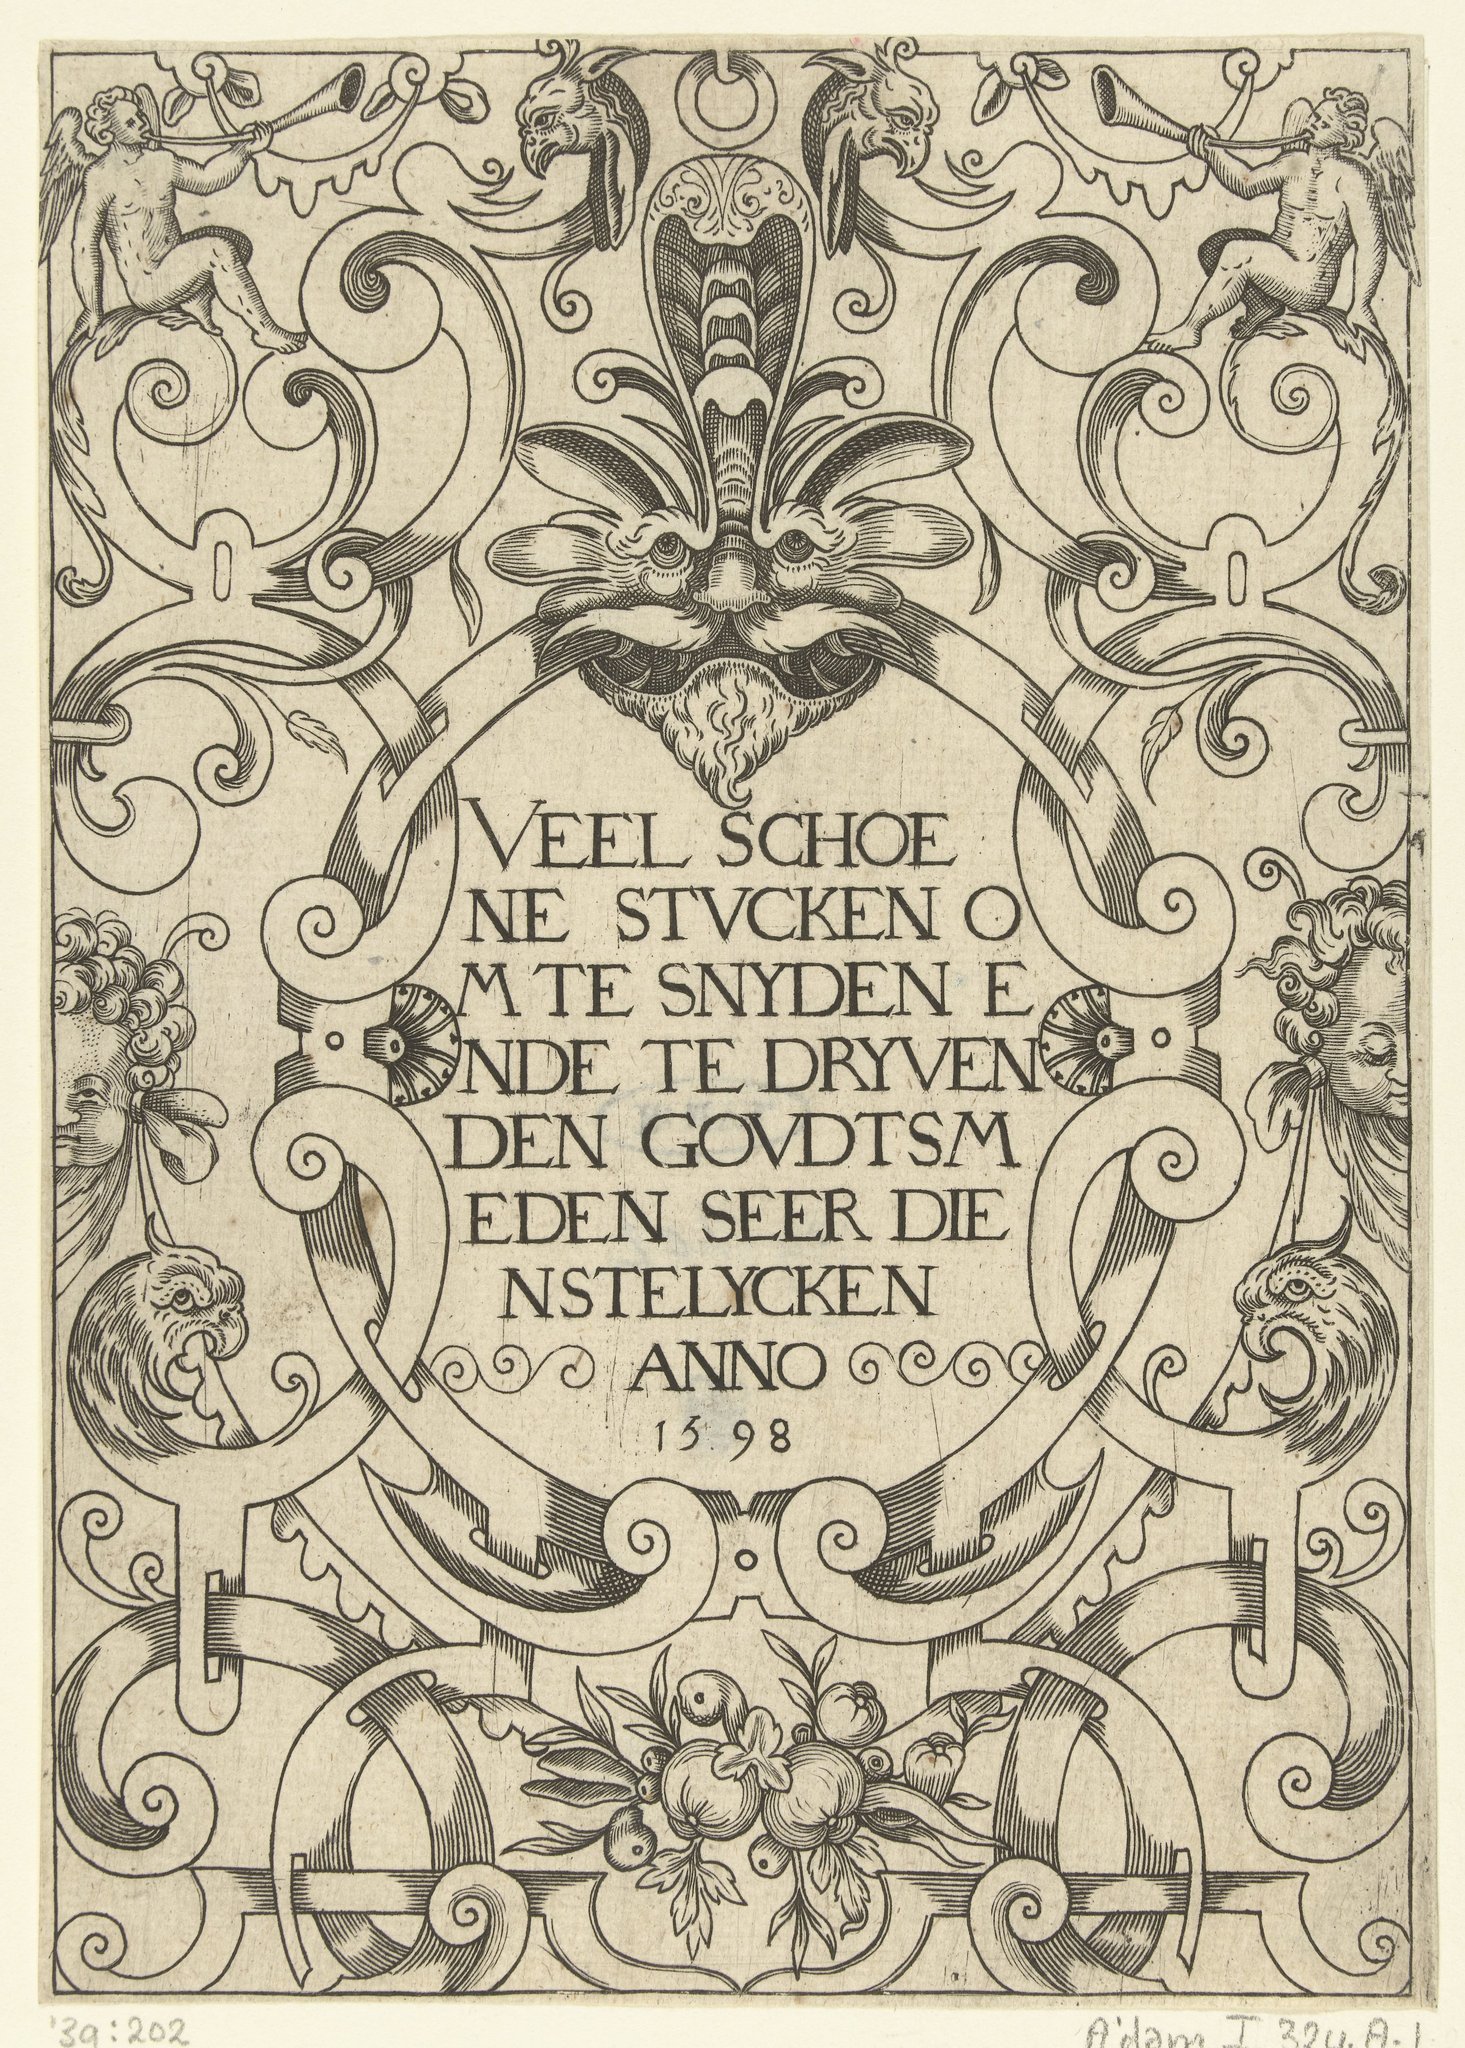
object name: titelblad, titelpagina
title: Bekers, bokalen en schalen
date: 1500-1598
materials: paper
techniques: engraving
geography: netherlands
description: Middenboven hangt een mascaron, middenonder een guirlande die is opgehangen aan de oren van twee mascarons. Linksboven en rechtsboven zit een engel die op een bazuin blaast. Gelijkzijdige kopieën van de onder Orn Cat I-324 vermelde serie. Titelblad en 13 bladen.